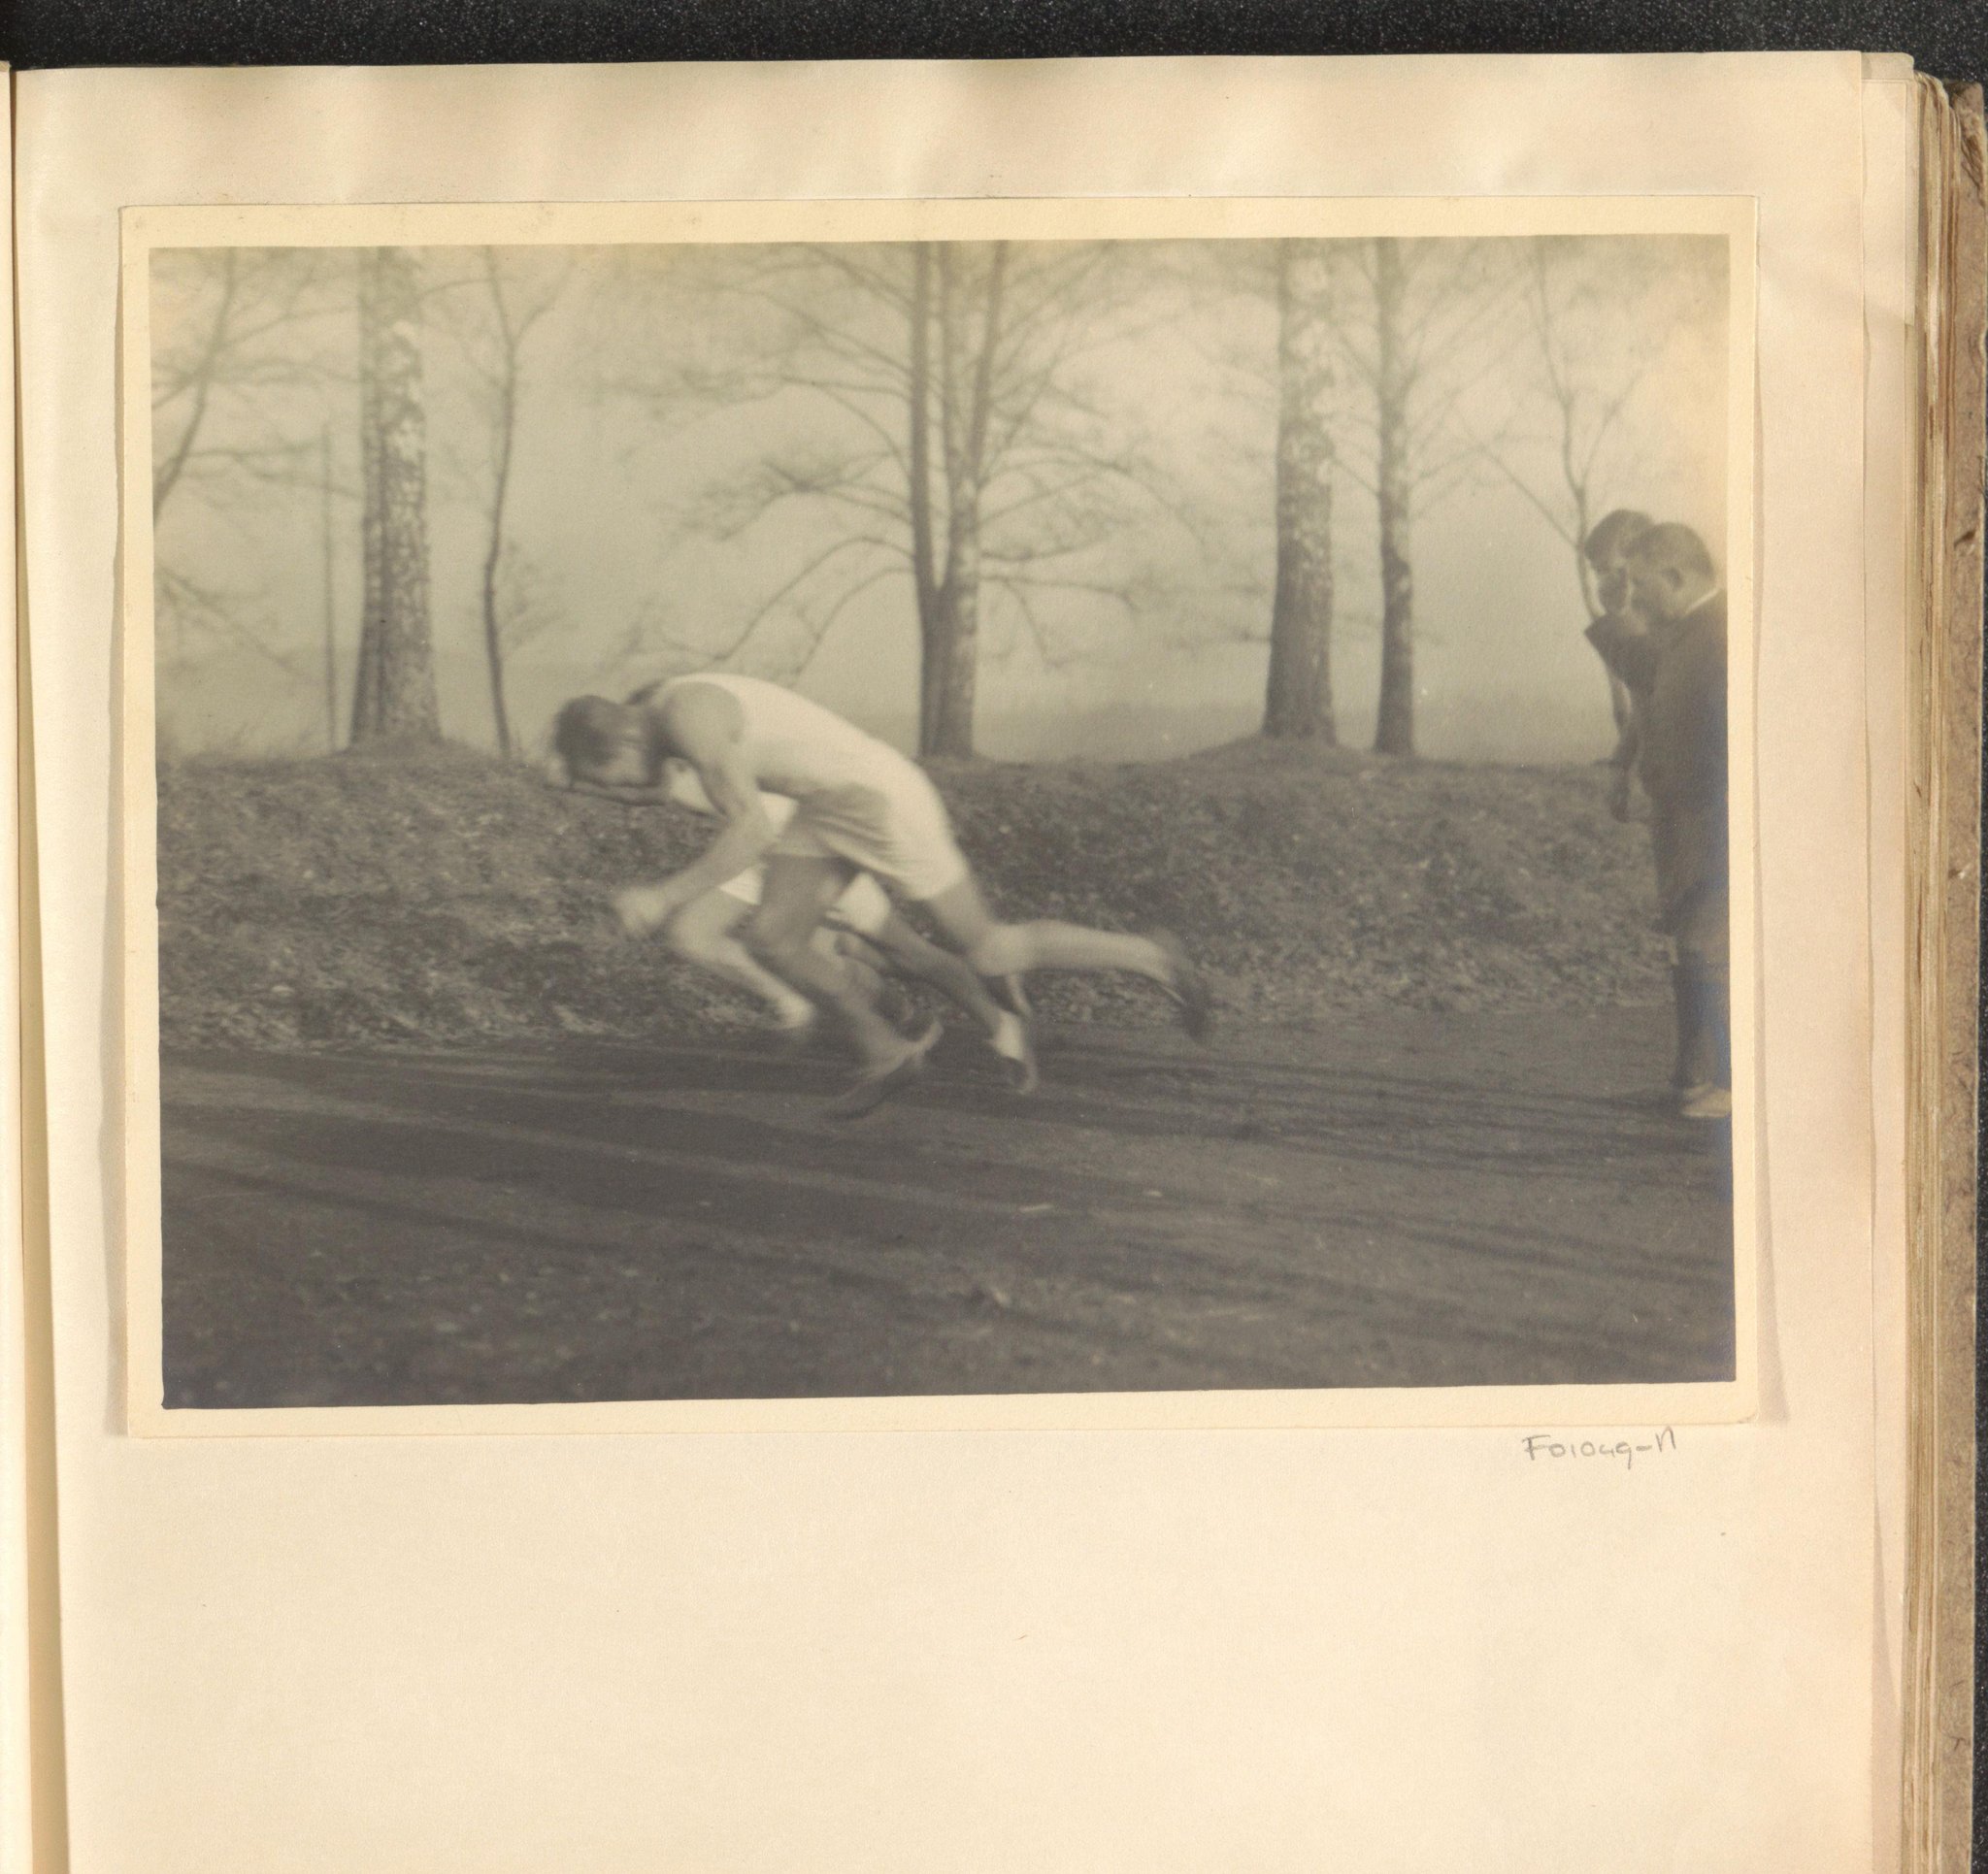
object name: photograph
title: Leerlingen van Schule Schloss Salem tijdens de atletiek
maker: Anonymous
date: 1929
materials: photographic support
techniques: gelatin silver print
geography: salem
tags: other athletic sport, running (~ game), education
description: Onderdeel van Fotoalbum van Schule Schloss Salem.